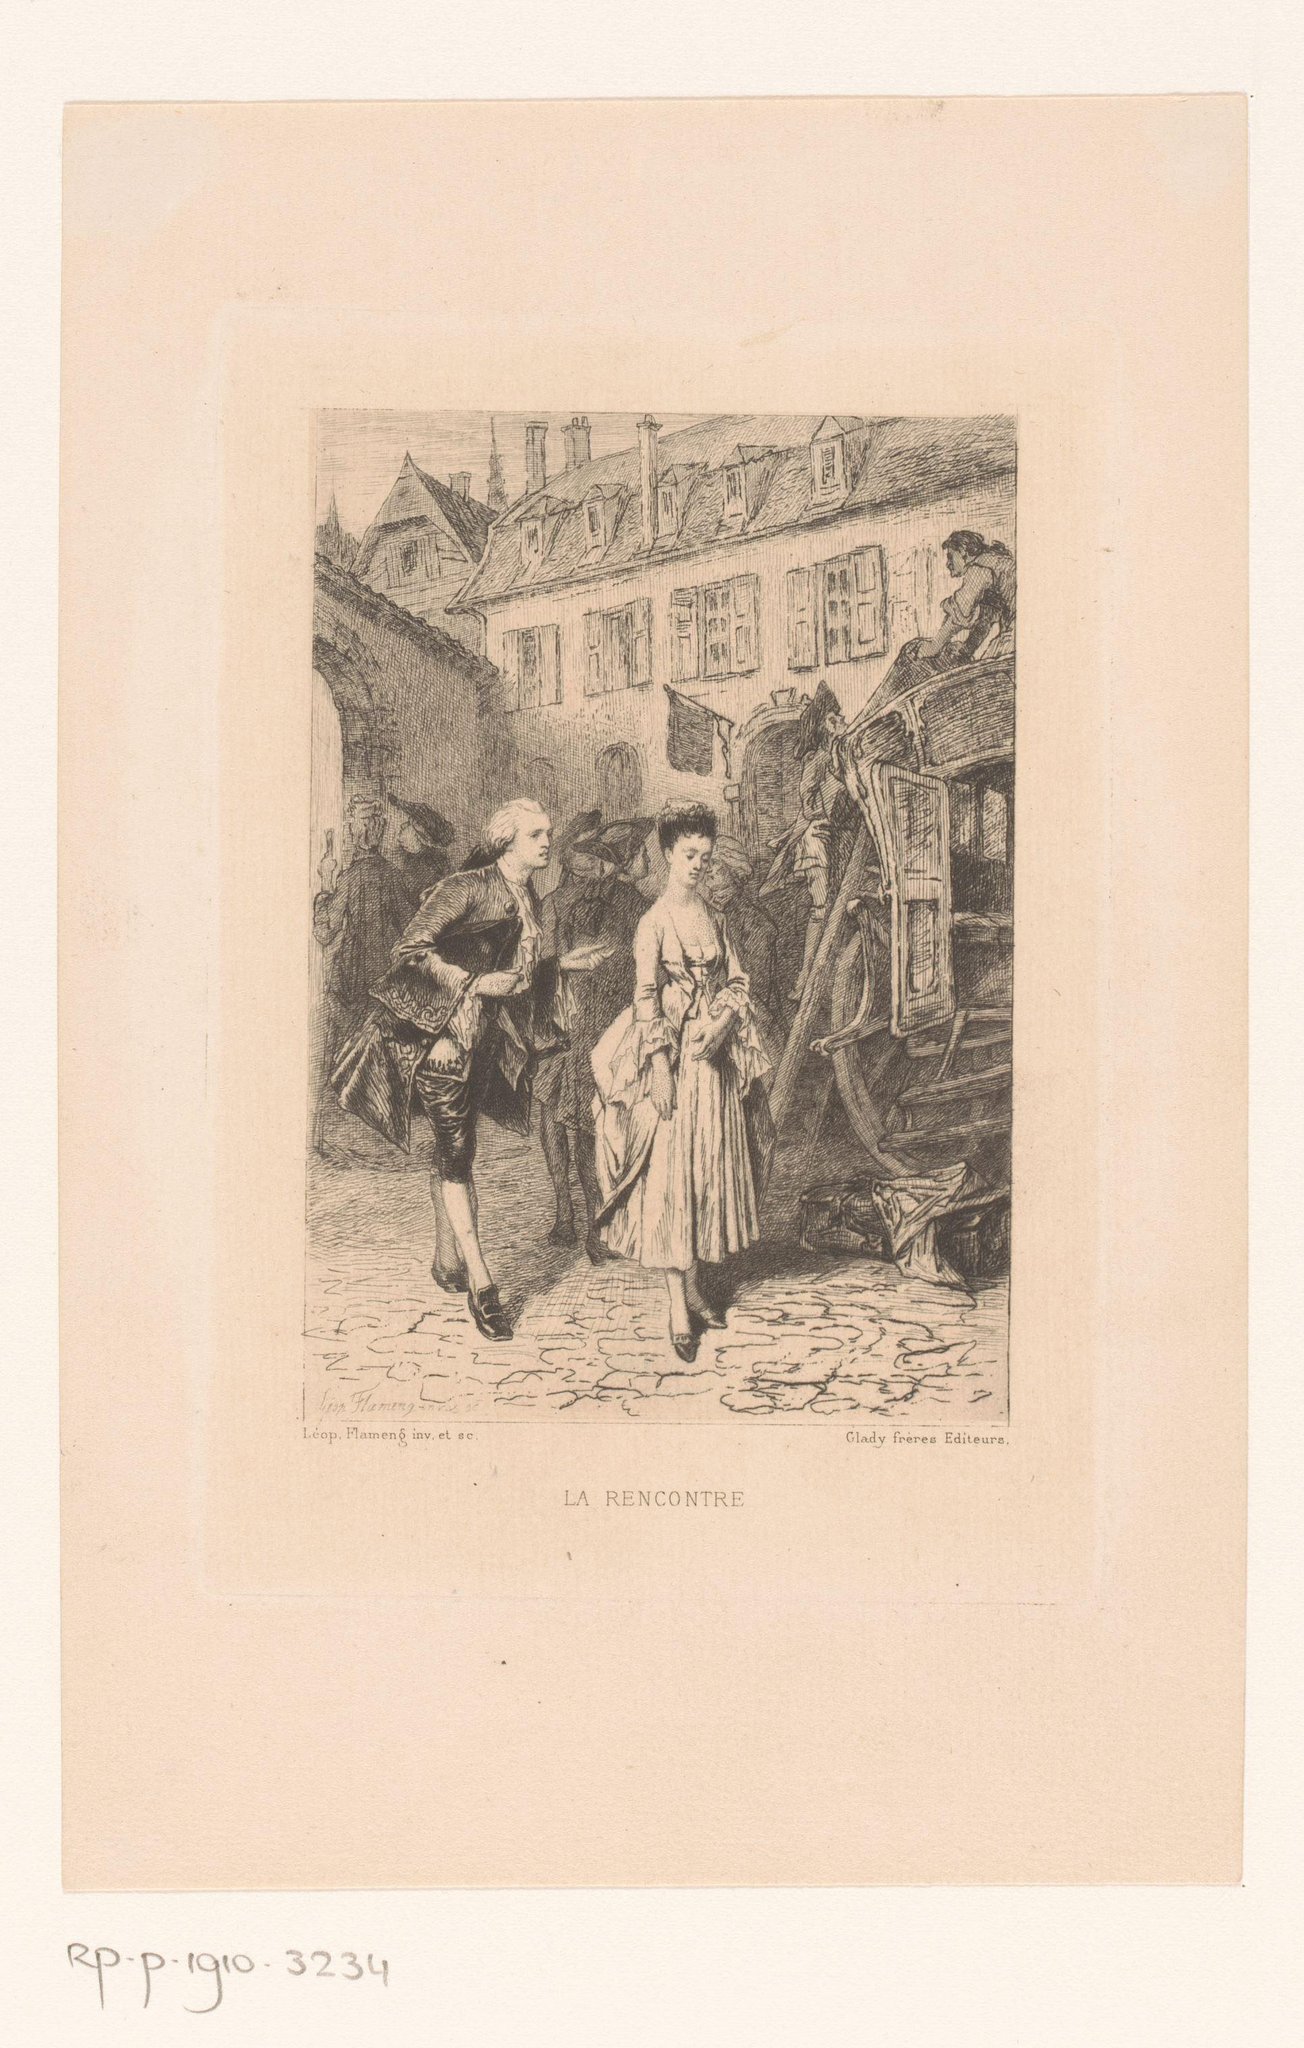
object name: book illustration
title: Ontmoeting tussen Manon Lescaut en Chevalier des Grieux bij een koets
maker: léopold flameng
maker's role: print maker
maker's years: 1831-1911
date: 1875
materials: paper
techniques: etching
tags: lovers' meeting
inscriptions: collector's mark: Lugt 2228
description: Prent uit: Prévost, Antoine François. Histoire de Manon Lescaut et du Chevalier Des Grieux (...). Paris: Glady frères, 1875.